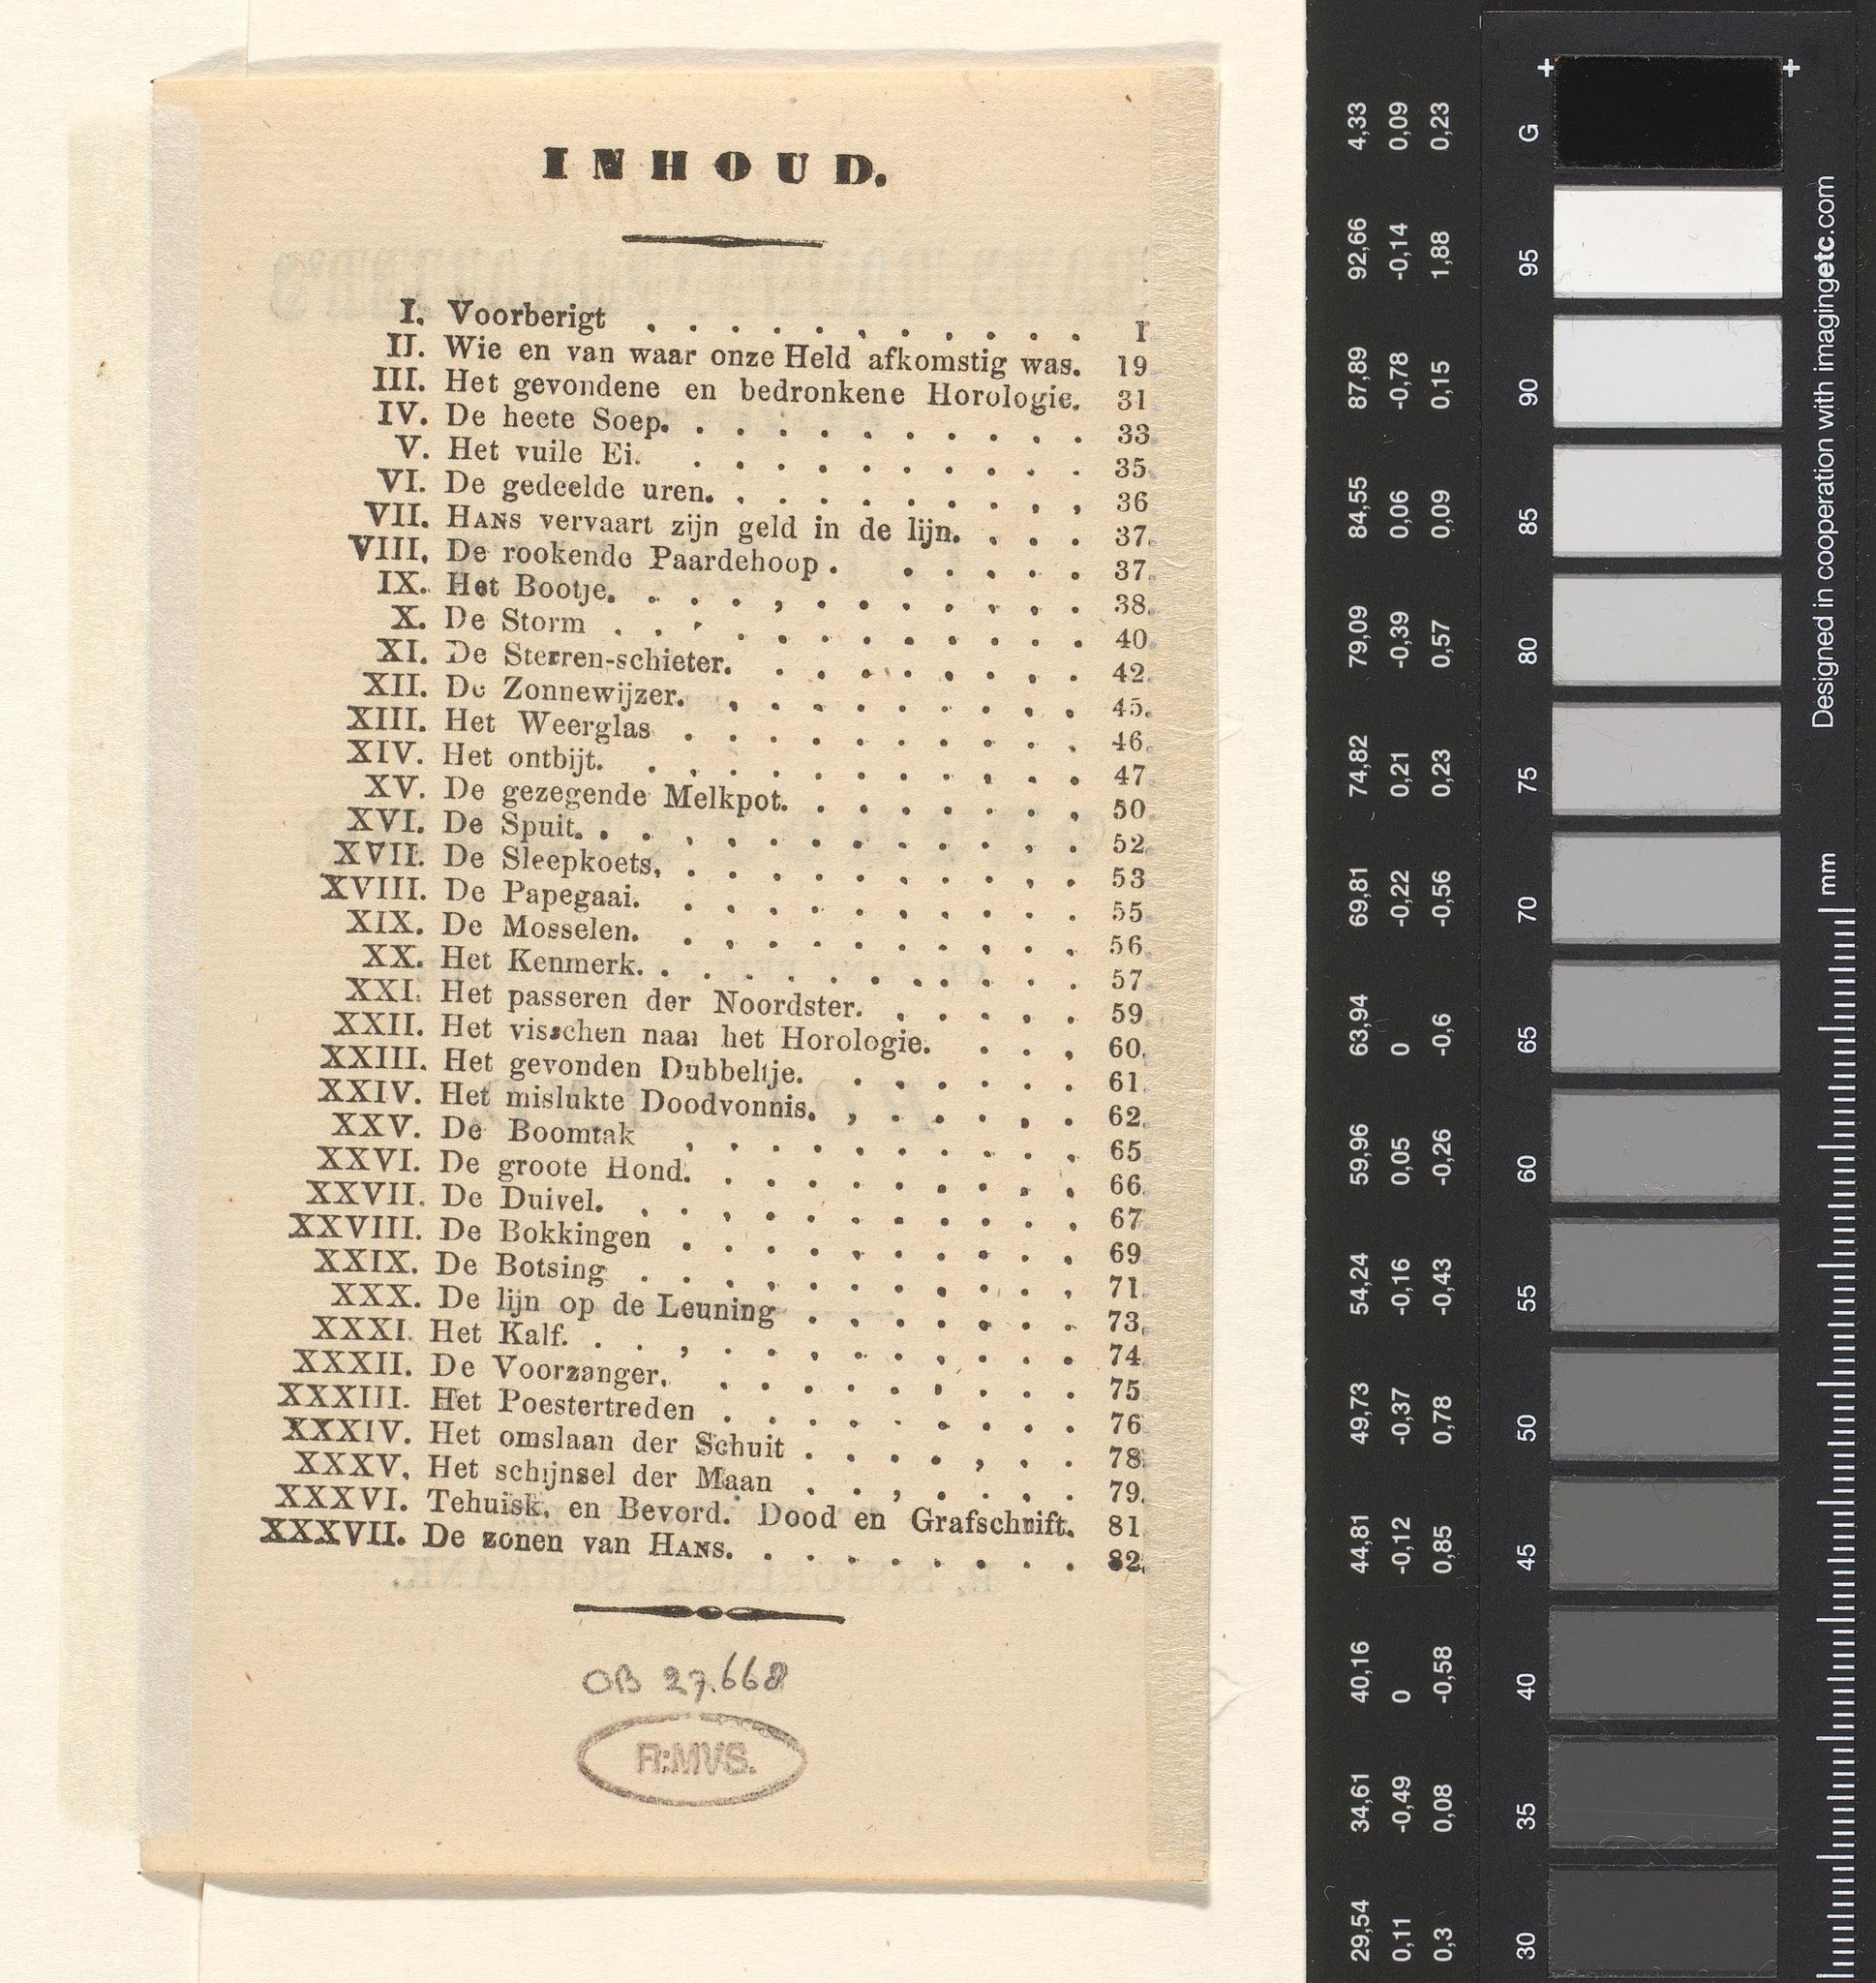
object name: print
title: Inhoudsopgave voor: Hans Hannekemaaijer's Bijzondere lotgevallen en ontmoetingen op zijne reis naar en door Holland, s.a.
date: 1827-1875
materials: paper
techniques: lithograph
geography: groningen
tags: printed matter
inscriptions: collector's mark: Lugt 2228